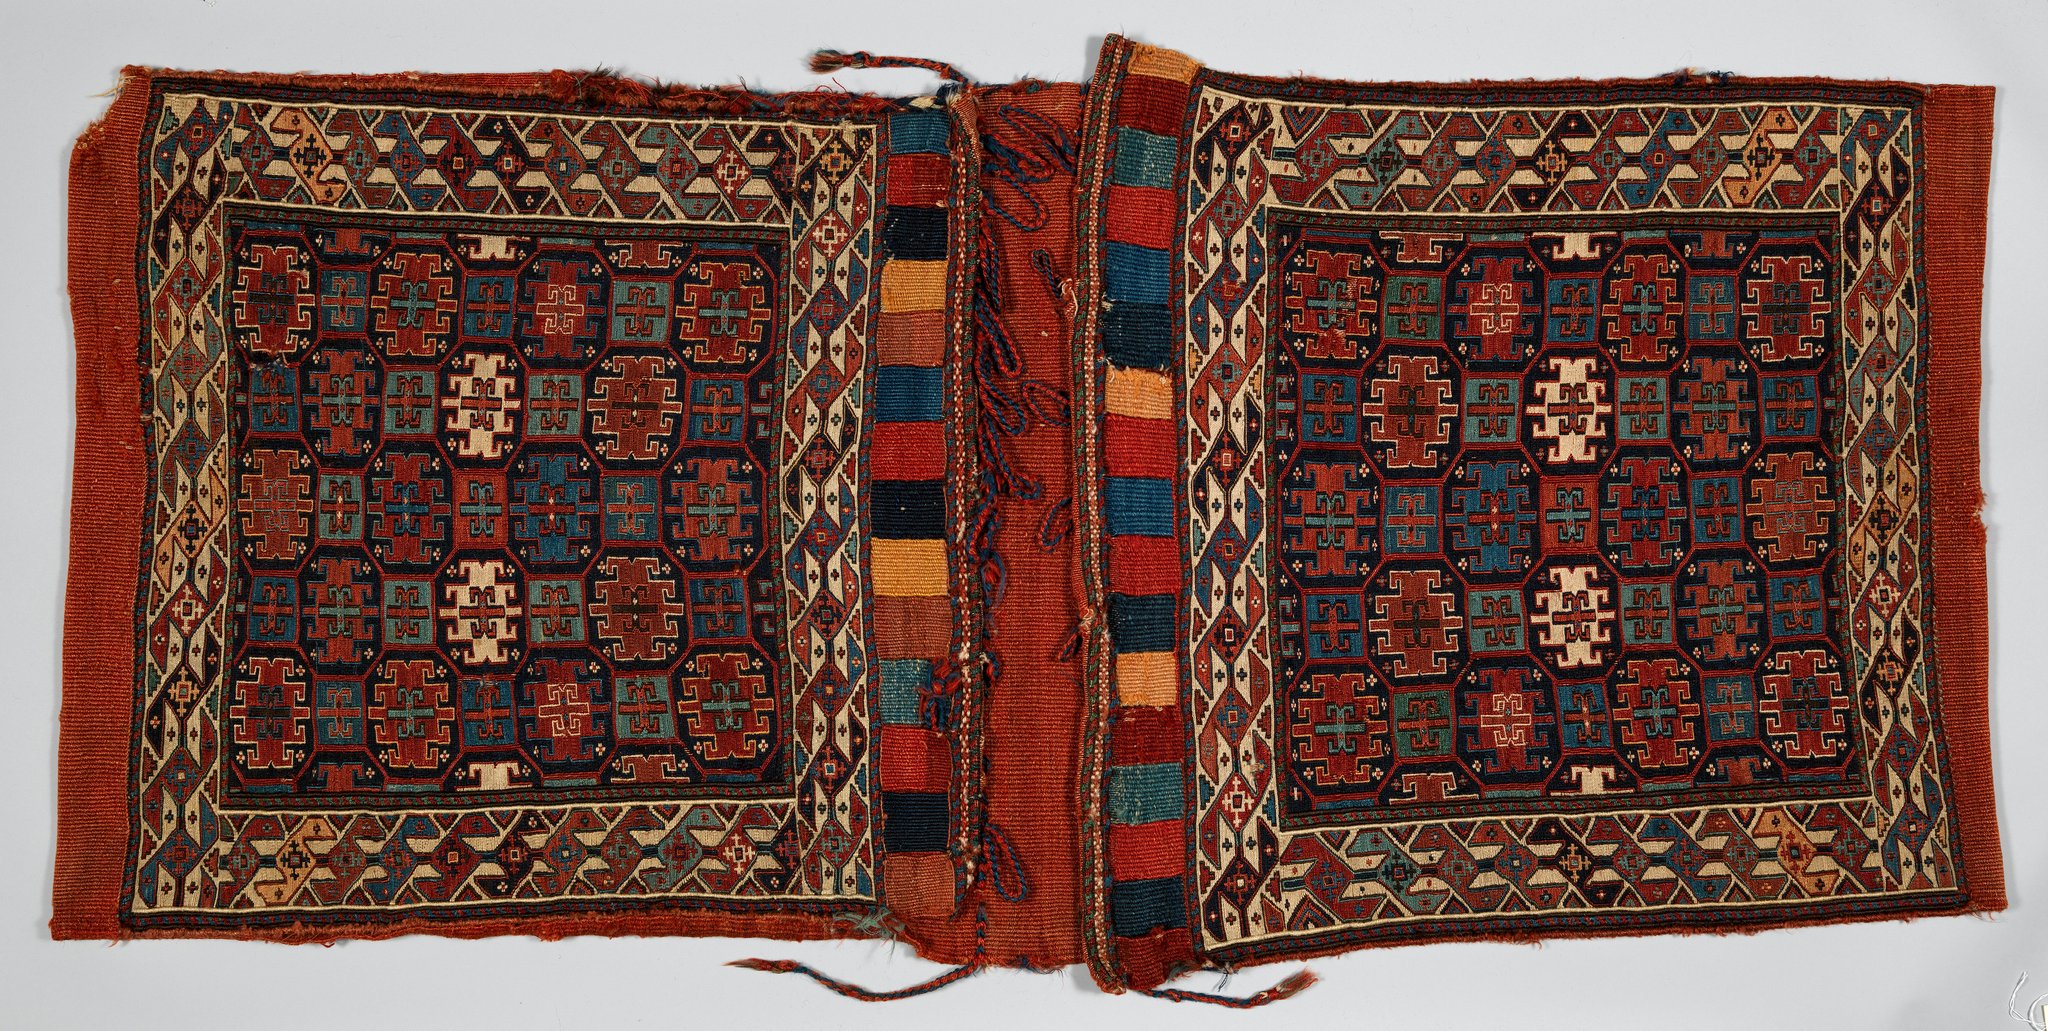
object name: saddle bag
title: Double Saddle Bag (Khorjin)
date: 1875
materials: hair, wool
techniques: weave, slit, tapestry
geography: northwestern iran